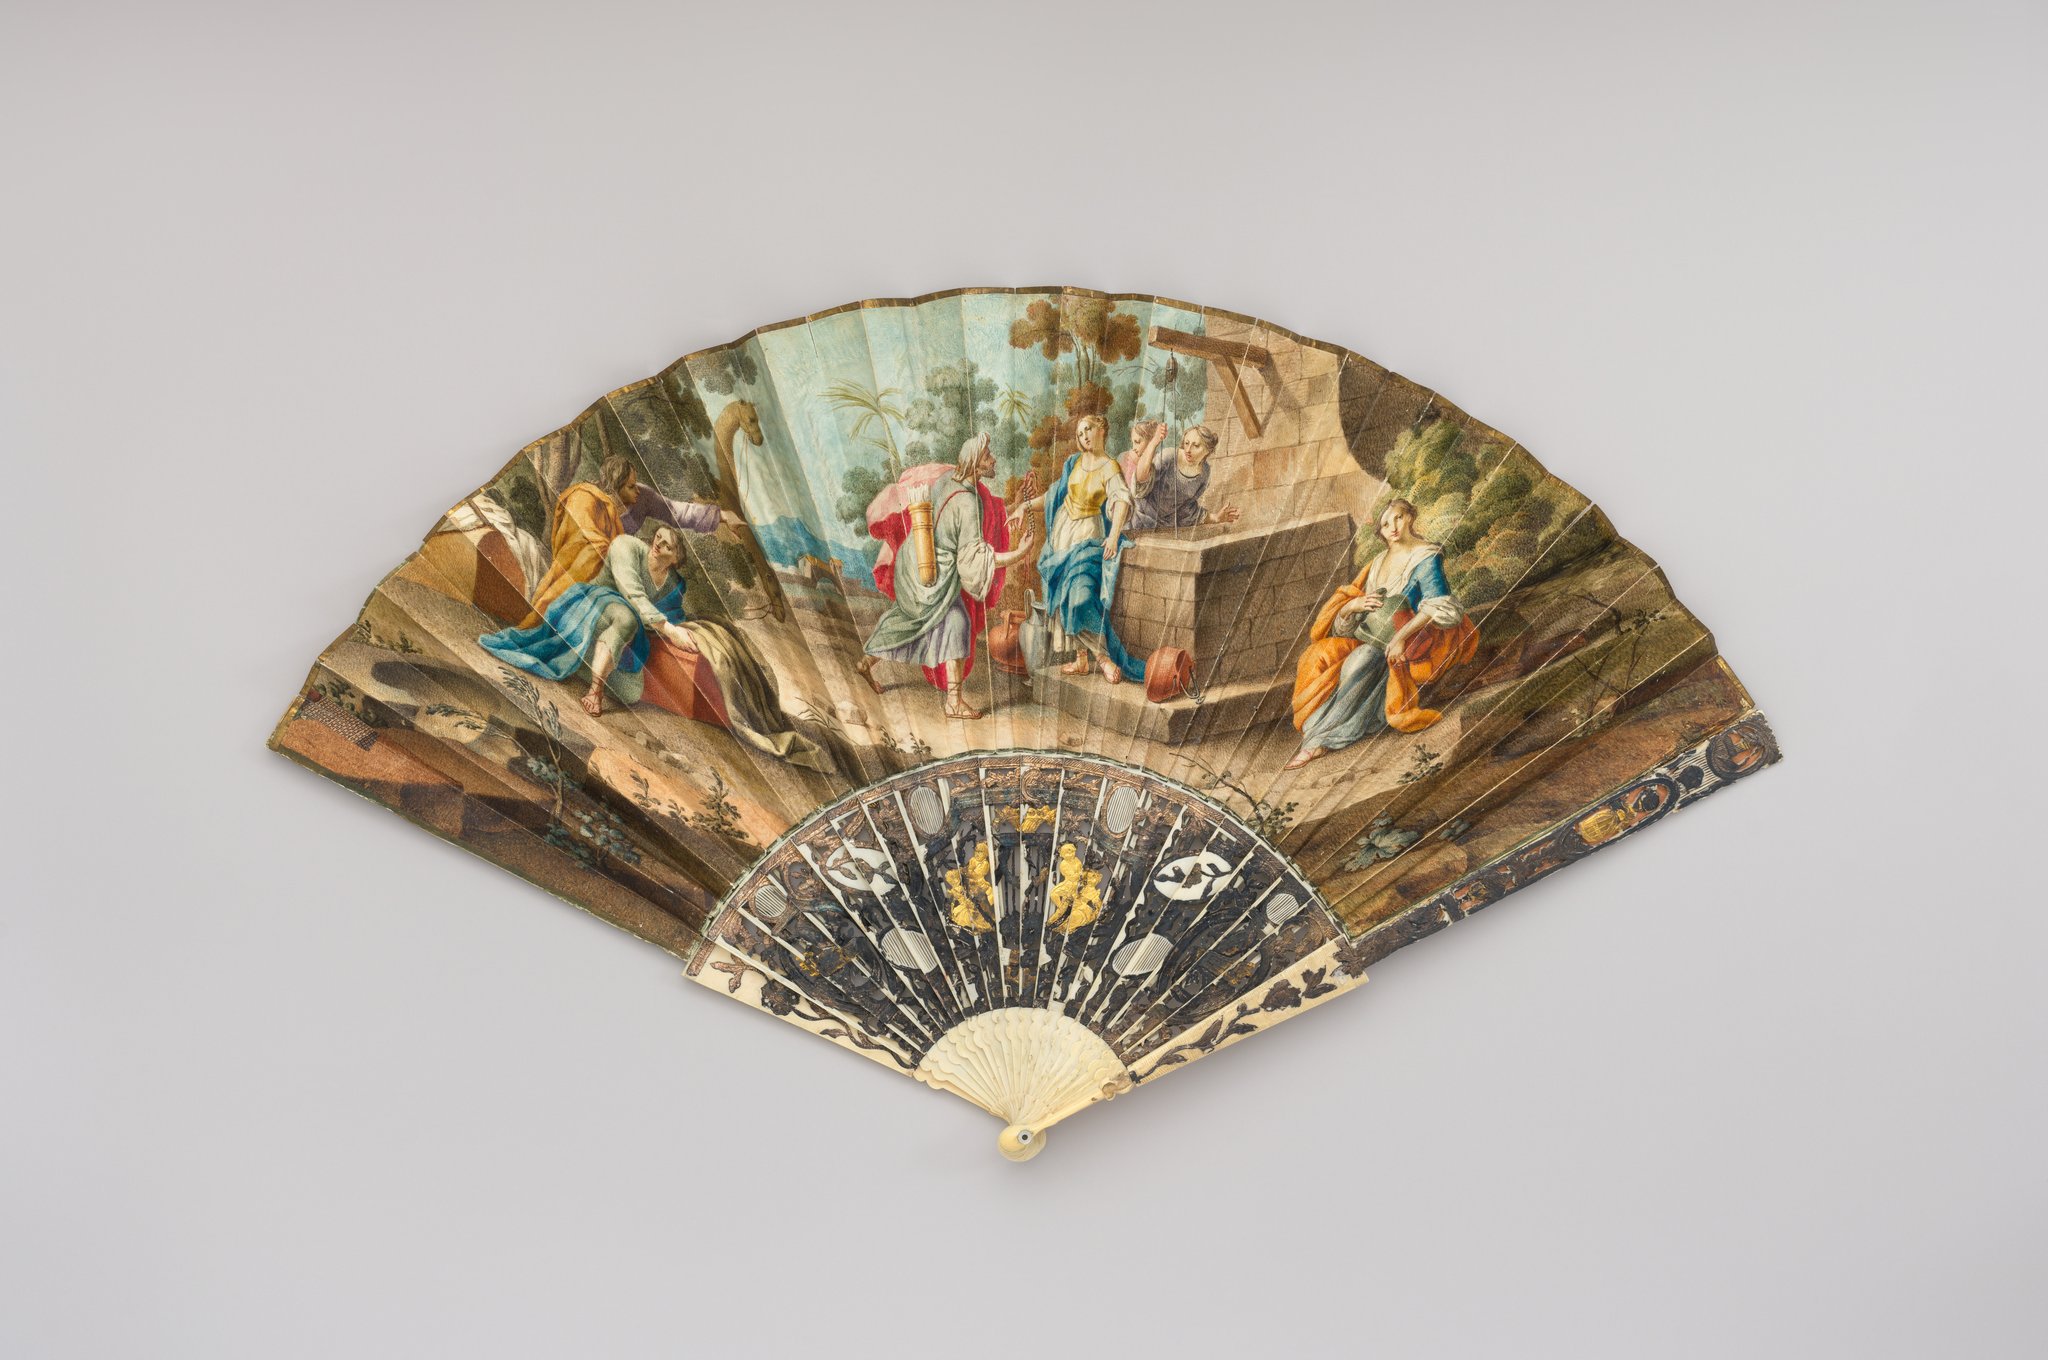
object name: fan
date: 1701-1733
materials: ivory, skin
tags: men,women